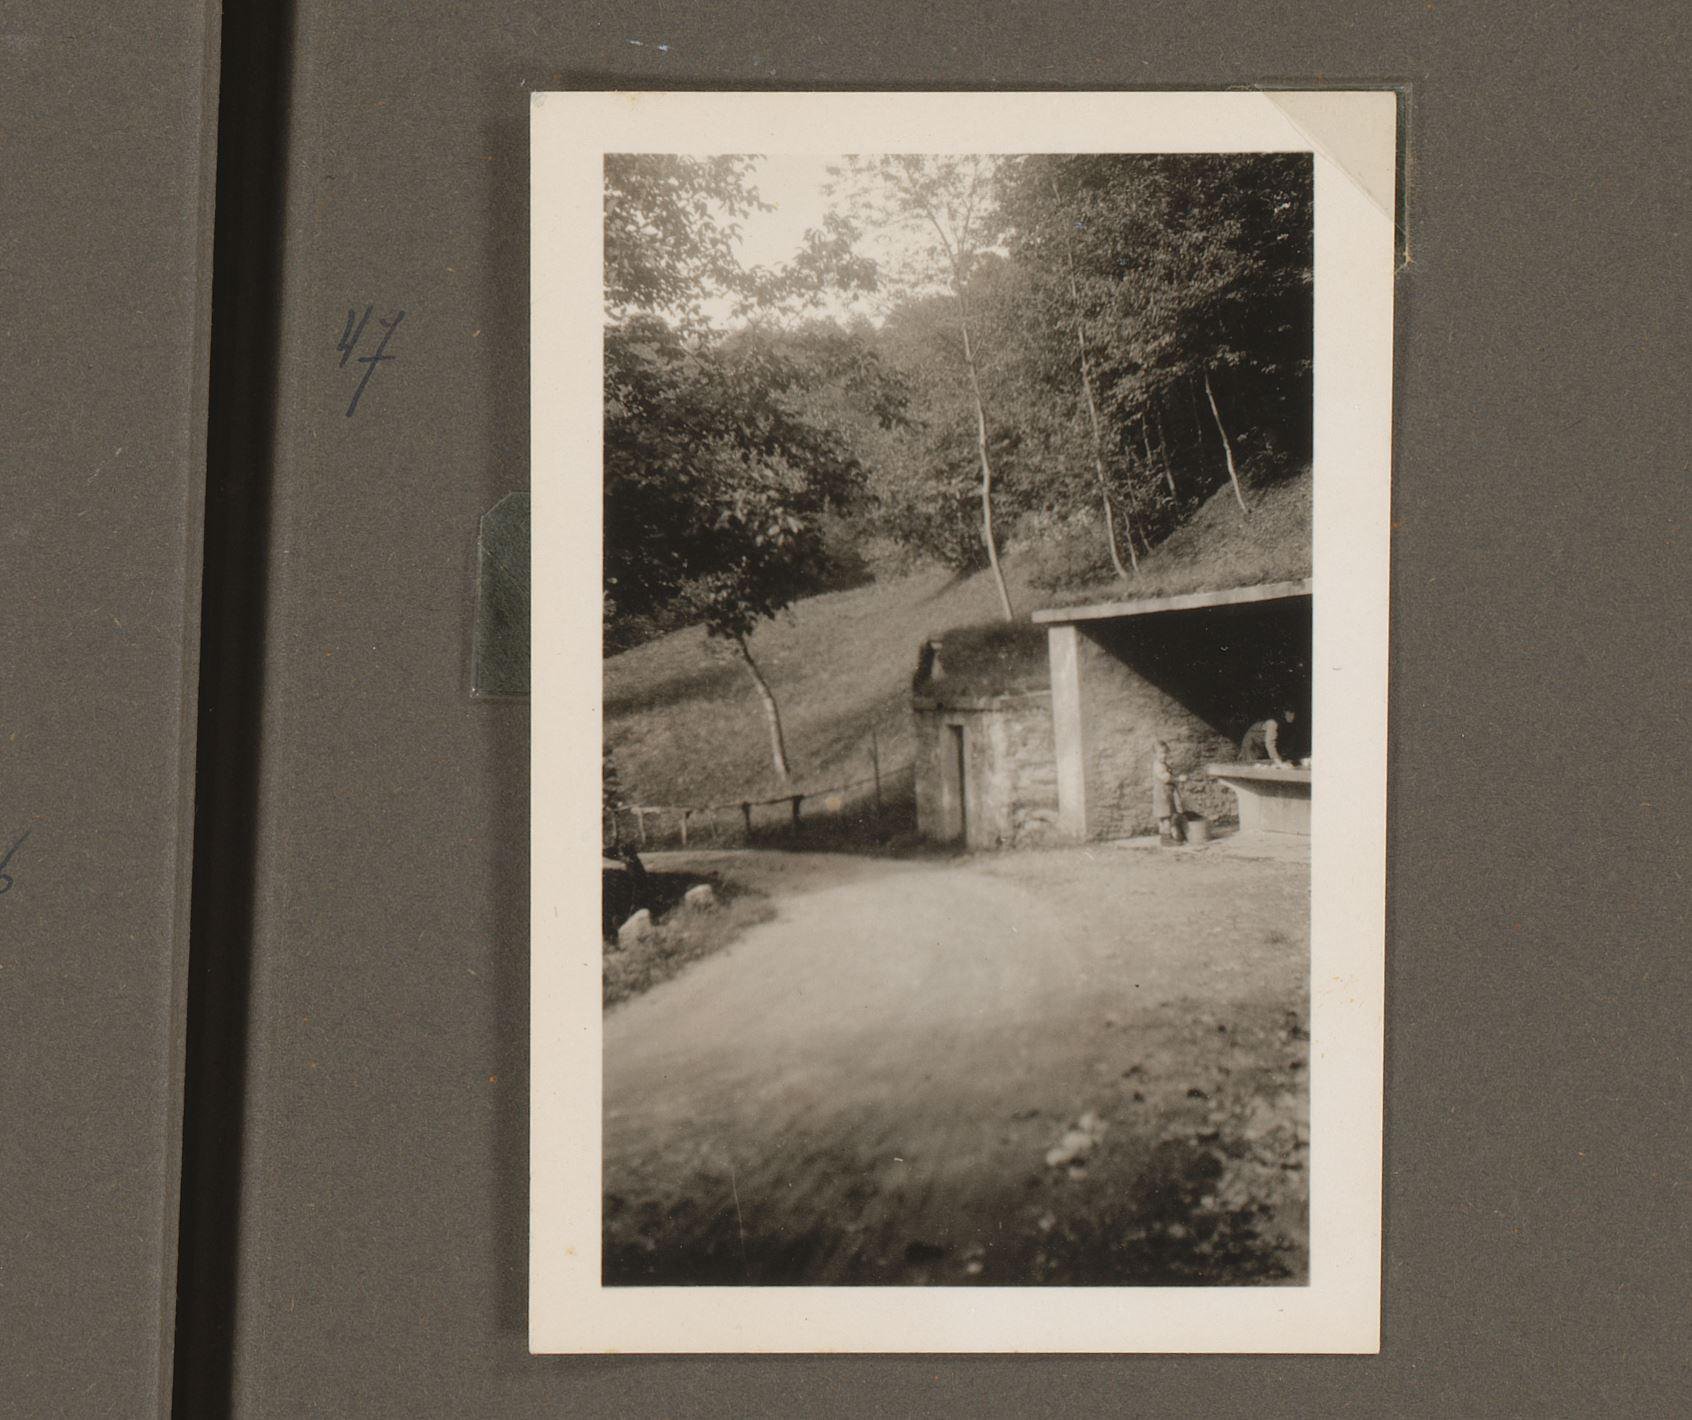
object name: album leaf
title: Waschgelegenheid in Bettagno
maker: Anonymous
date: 1933-1934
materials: photographic support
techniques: gelatin silver print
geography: cagiallo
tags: public wash house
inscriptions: number: ‘47’